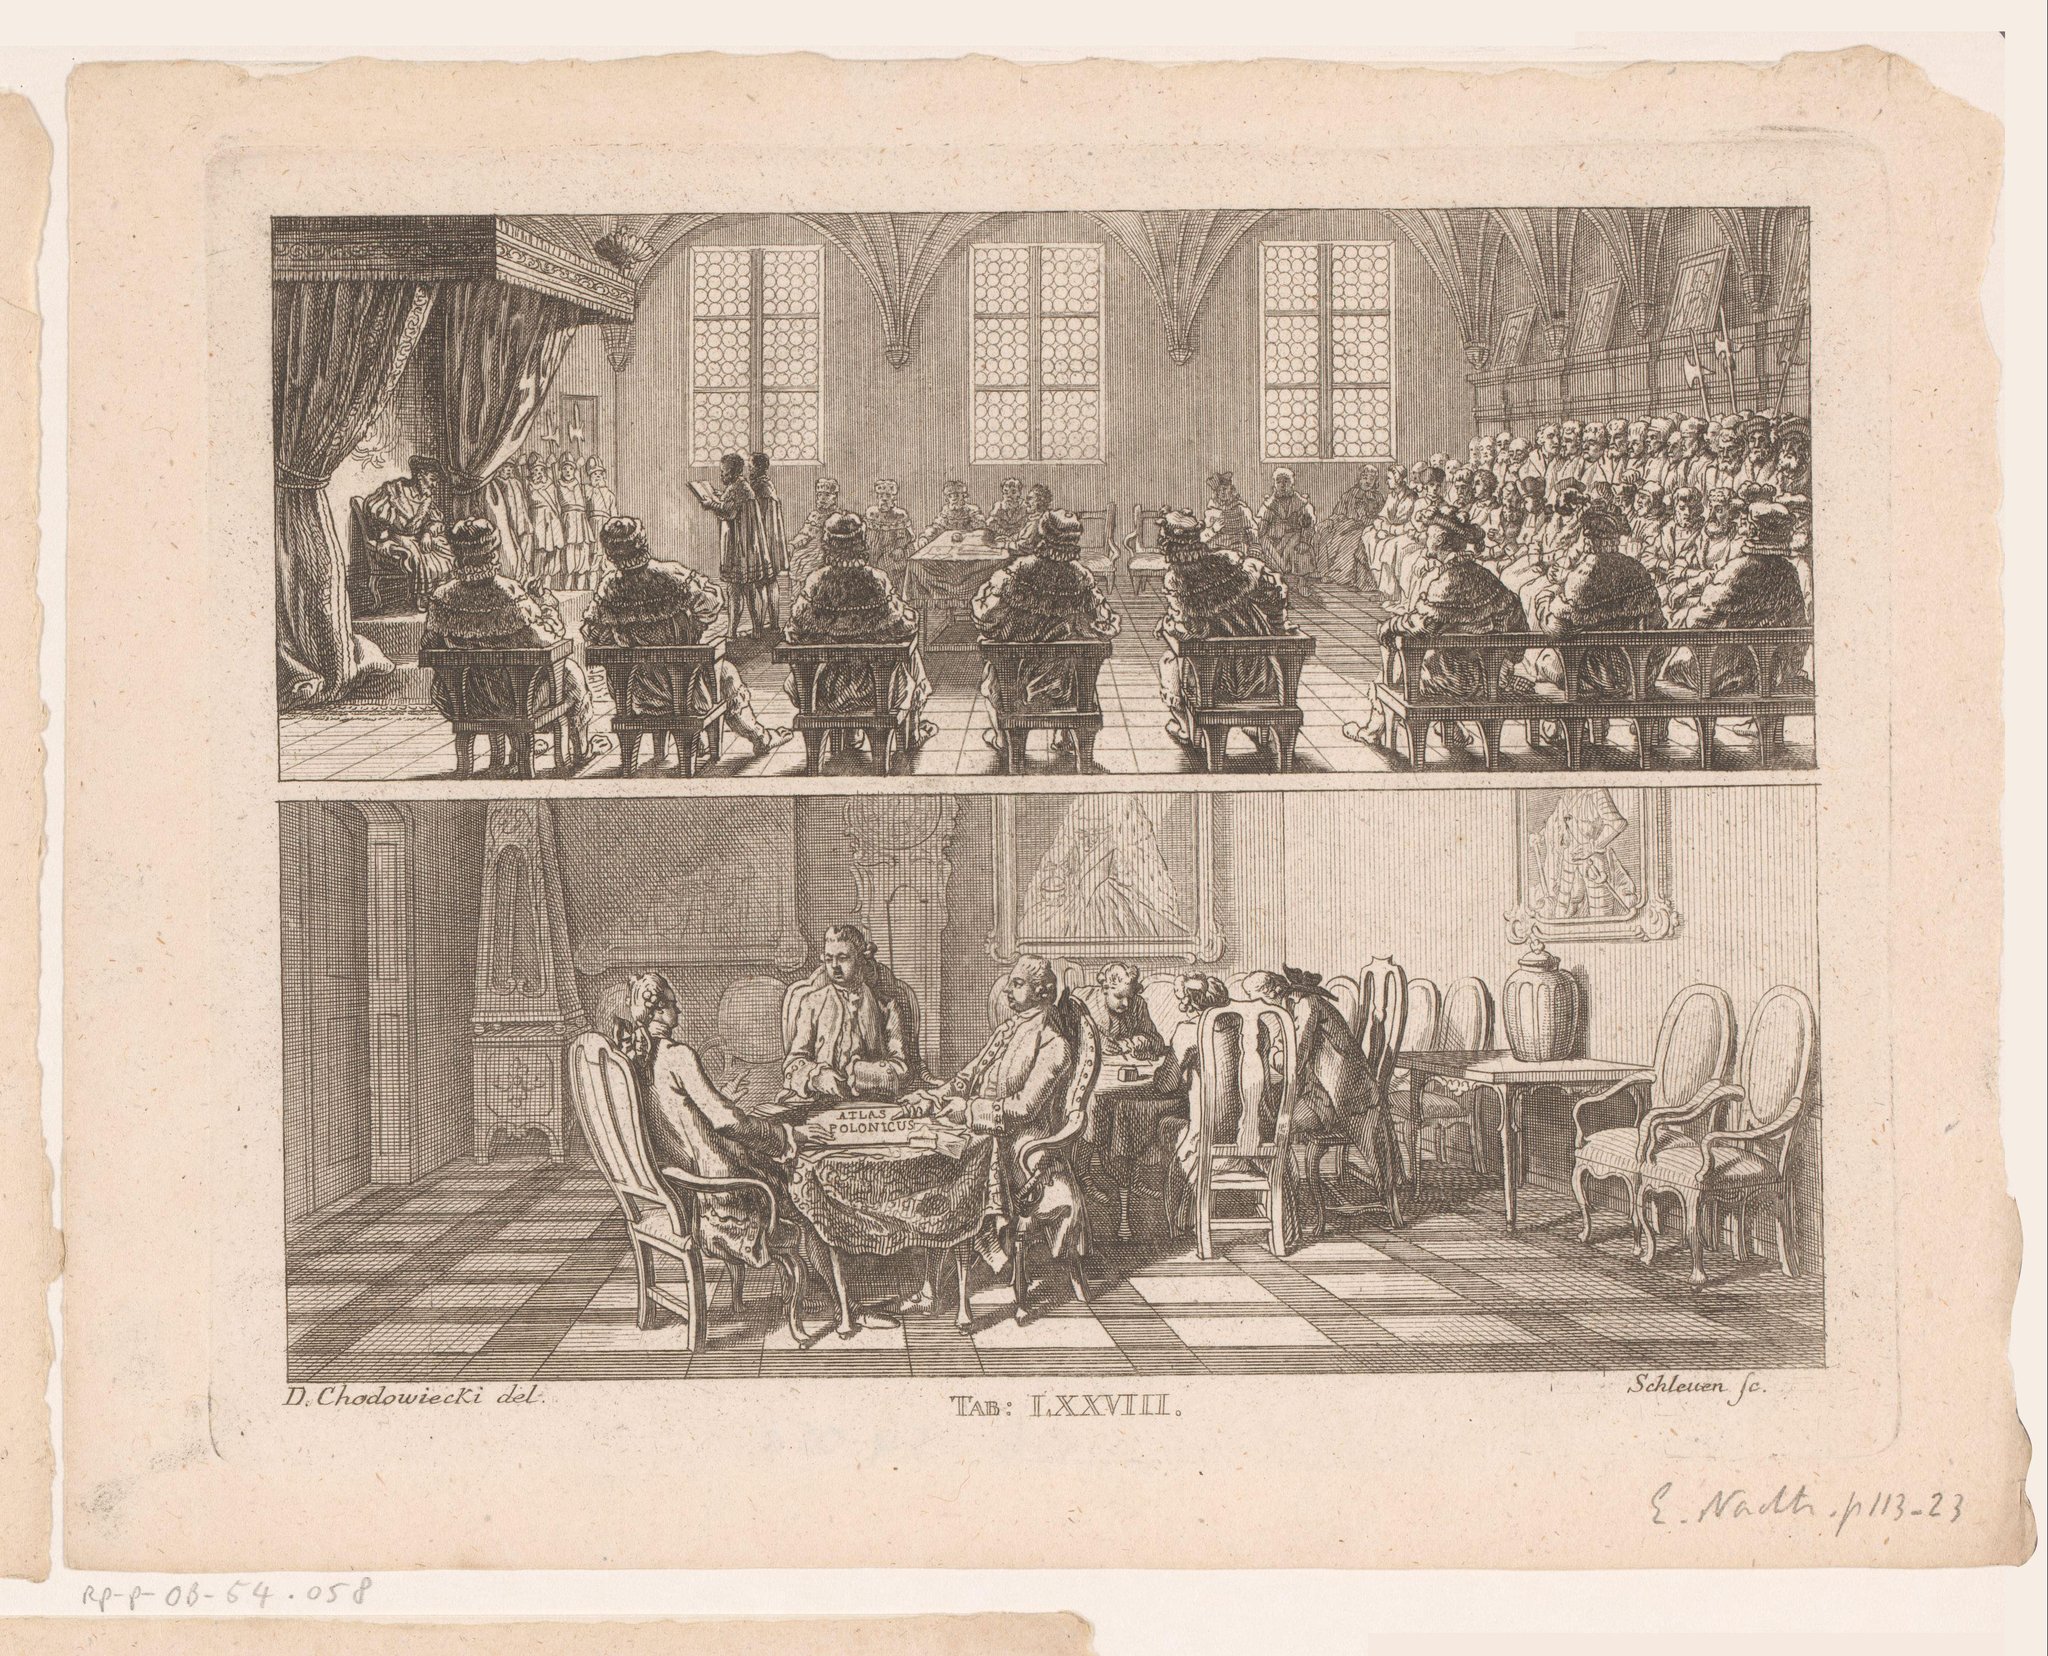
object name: print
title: Twee encyclopedische voorstellingen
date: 1765-1806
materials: paper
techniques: etching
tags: state; law; political life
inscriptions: collector's mark: Lugt 2228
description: Prent ook gebruikt in: Allgemeine deutsche Bibliothek. Berlijn en Stettin: Friedrich Nicolai, 1765-1806.